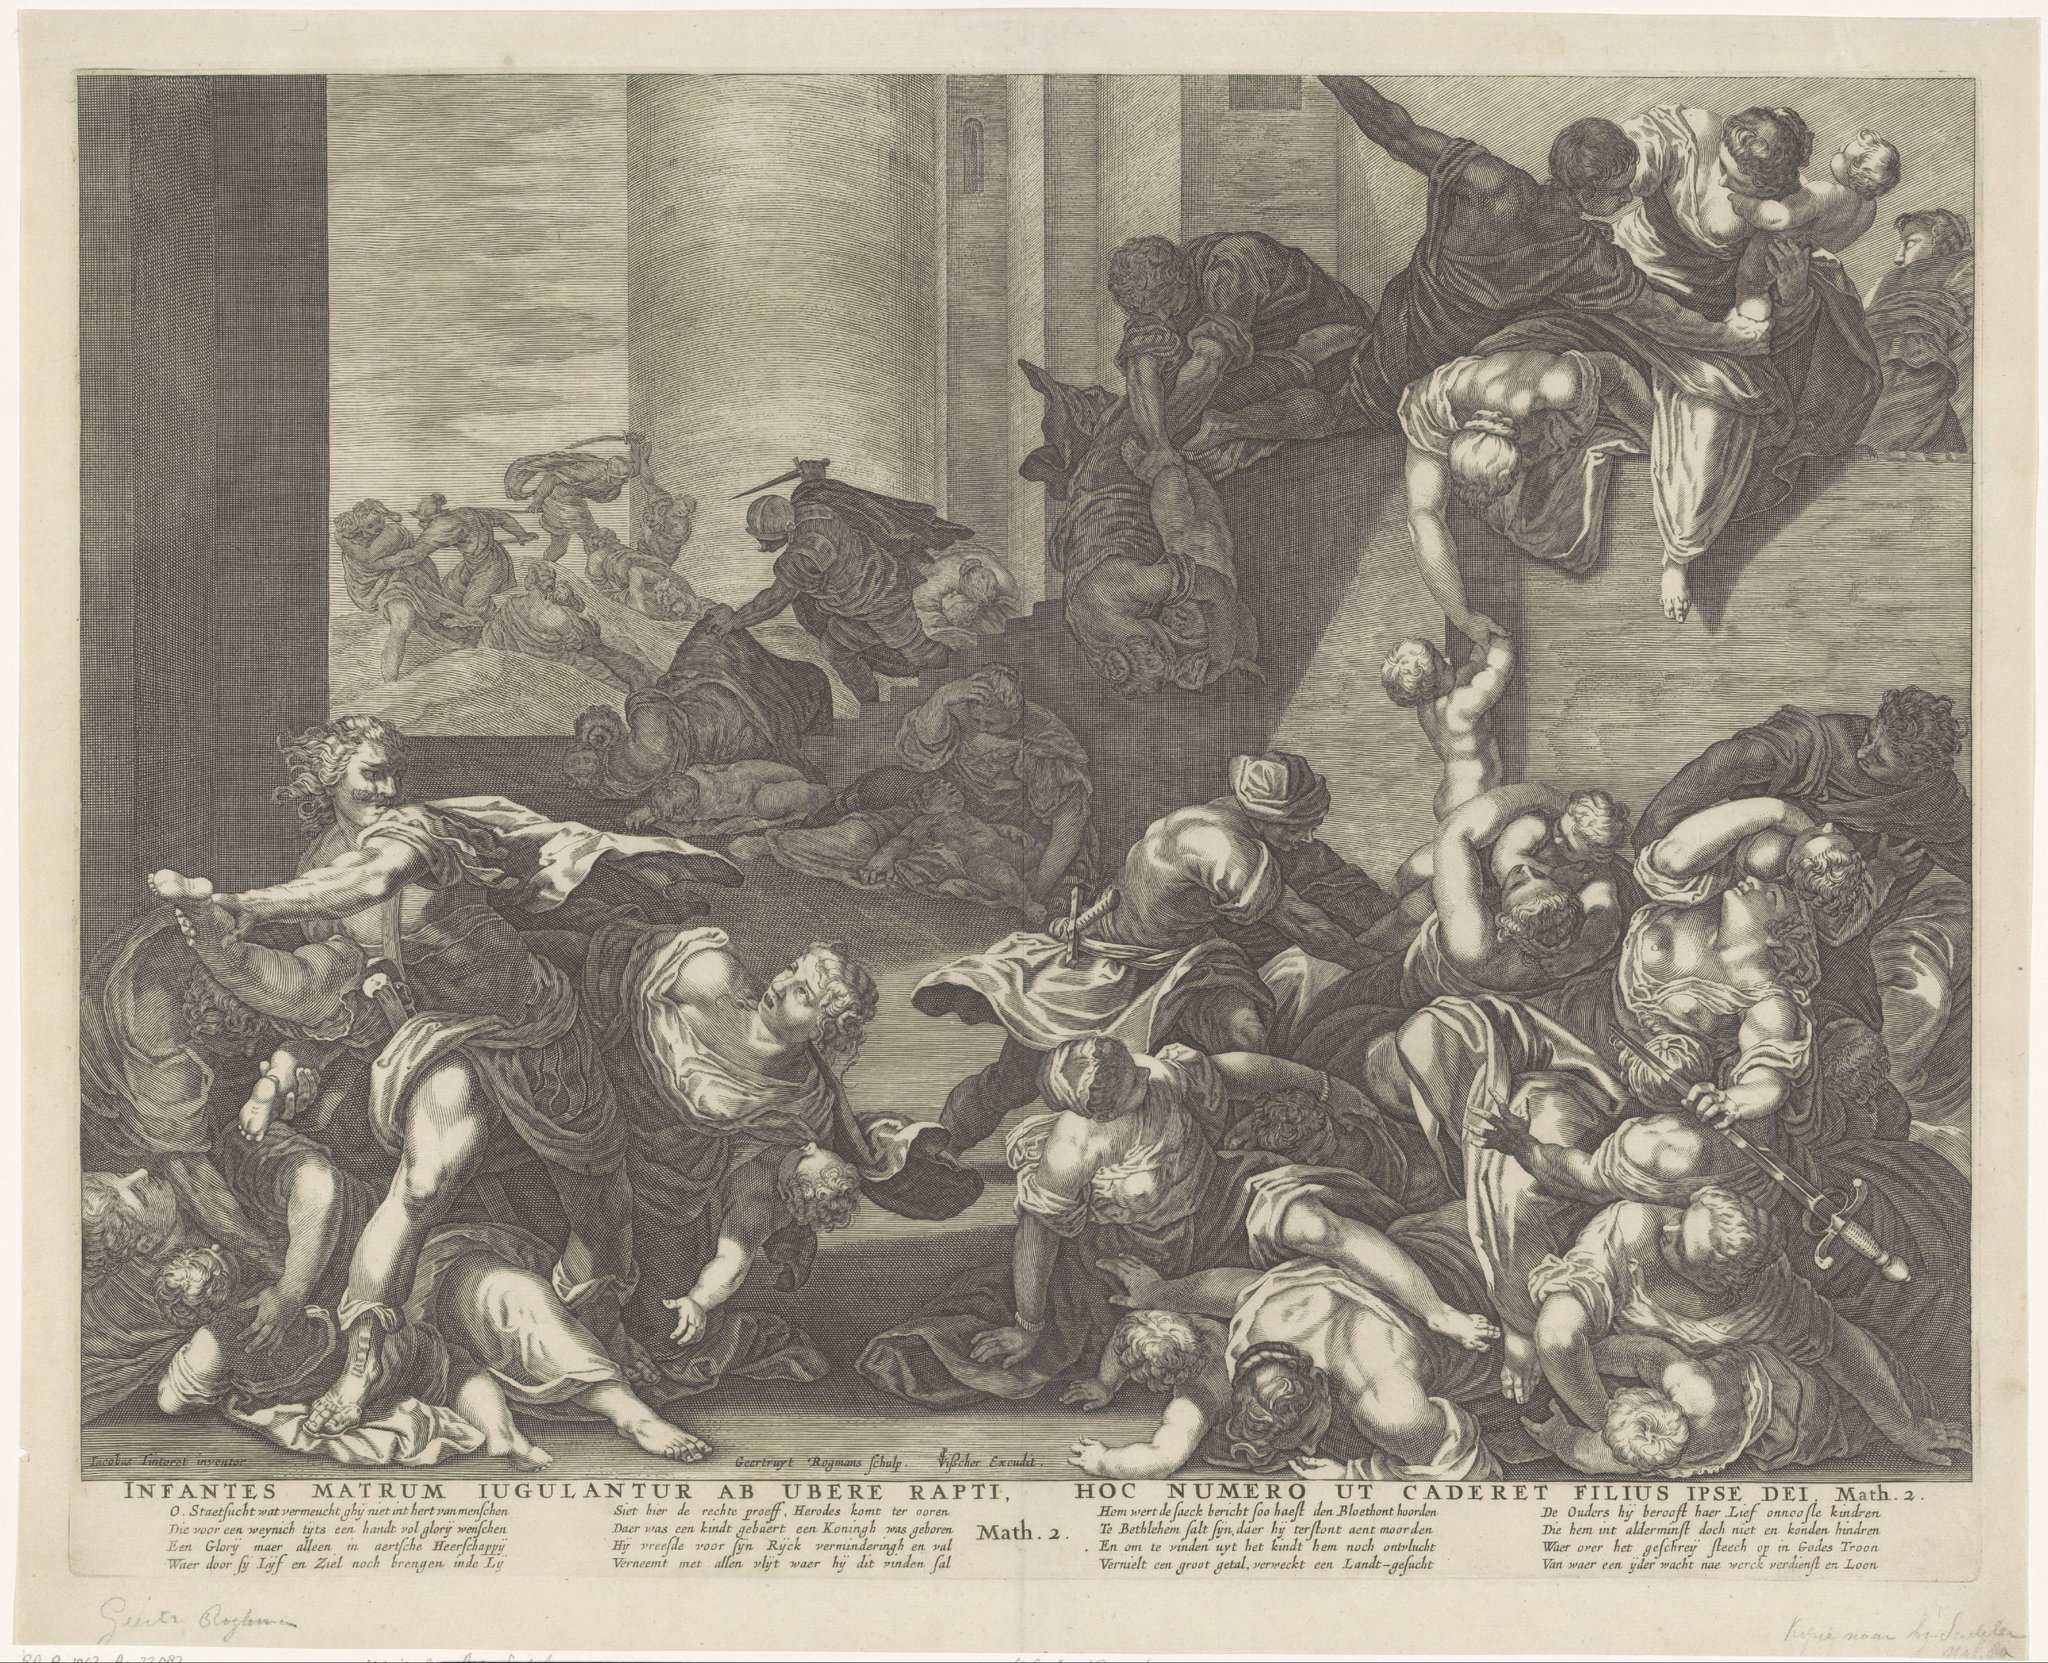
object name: print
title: Infantes matrum iugulantur ab ubere rapti, hoc numero ut caderet filius ipse dei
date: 1630-1652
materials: paper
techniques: engraving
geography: amsterdam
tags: the massacre of the innocents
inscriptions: collector's mark: Lugt 2228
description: De Amsterdamse uitgever Claes Jansz. Visscher (II) produceerde vanaf de jaren ’30 van de zeventiende eeuw grote Bijbelse prenten op zogenaamd royaal-formaat papier (ca. 480 x 580 mm). Na zijn dood in 1652 zette zijn zoon Nicolaes Visscher (I) het bedrijf voort en zo ook de uitgave van Royaalbijbelprenten. Toen Nicolaes in 1679 overleed nam zijn zoon Nicolaes Visscher (II) het bedrijf over en gaf kort hierna, omstreeks 1680, een fondslijst uit. Hierin worden 130 prenten met Bijbelse voorstellingen op royaalpapier beschreven (zie documentatie J. van der Waals). Complete prentbijbels op royaal-formaat werden door vader en zoon Nicolaes Visscher uitgegeven onder de titel Historiae Sacrae Veteris et Novi Testamenti. De bladen werden echter ook los verkocht en konden worden gecombineerd met Royaalbijbel-prenten van andere uitgevers. Verschillende Amsterdamse uitgevers brachten namelijk ook bijbelprenten op royaal-formaat uit, onder wie Clement de Jonghe en Cornelis Danckerts. De door de firma Visscher uitgegeven prenten zijn veelal vervaardigd door anonieme prentmakers naar voorbeeld van verschillende zestiende- en zeventiende-eeuwse Bijbelse prenten en prentreeksen. Veelal moesten de composities worden aangepast aan het grotere en langgerekte royaal-formaat. Daarnaast zijn er ook grote bladen van bekende prentmakers zoals Jan van Londerseel, Pieter Nolpe, Jacques de Gheyn (II) en Jan Harmensz. Muller opgenomen in de categorie ‘Bybelsche Figuren, op Royaal-bladen’ in de fondslijst van Visscher. Prent mogelijk gebruikt in: Historiae Sacrae Veteris et Novi Testamenti (Royaalbijbel). Amsterdam: Nicolaes Visscher (I) en (II), [1652-1702]. In de fondslijst van Nicolaes Visscher II (ca. 1680) is het onderwerp van deze prent onder de titel 'Bybelsche Figuren, op Royaal-bladen. bestaande uyt de volgende historien.' als volgt genummerd: 73.